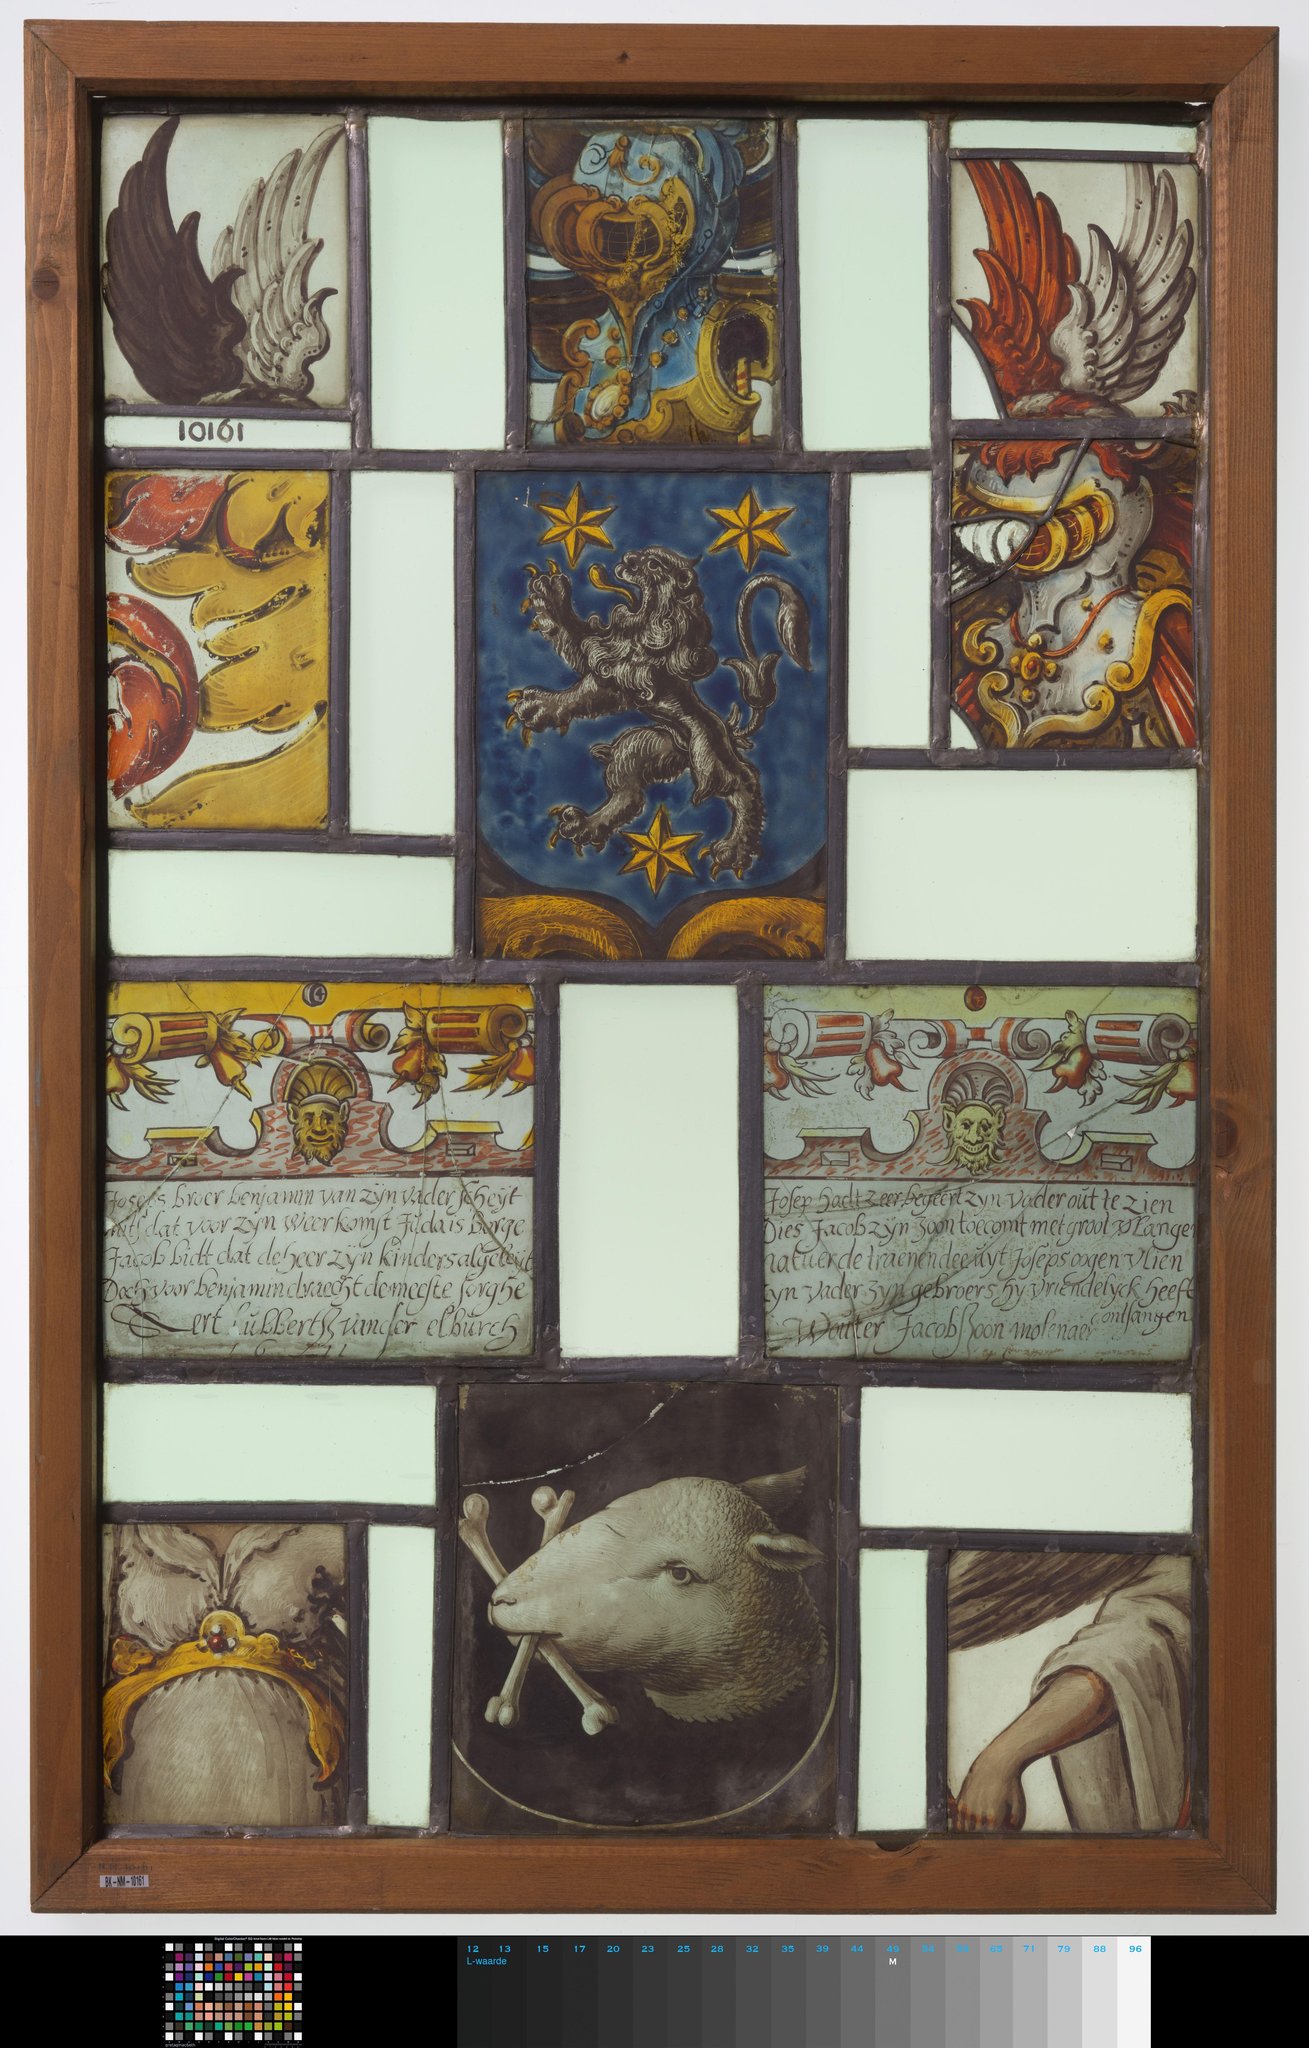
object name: light window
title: Ruit met fragmenten van een wapenschild met helm, klimmende leeuw, lambrequins, cartouches met inscripties en een schild met schapenkop met beenderen in de bek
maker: Anonymous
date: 1600-1699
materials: glass, lead, pigment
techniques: leading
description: Ruit met fragementen van een wapenschild met helm, klimmende leeuw, lambrequins, cartouches met inscripties en een schild met schapenkop met beenderen in de bek. Inscripties betrekking hebbende op Jozef en Benjamin, waaronder "Bert Lubbertz. van der Elburch 1611" en de ontmoeting van Jozef en Jacob, waaronder "Wouter Jacobszoon Molenaar en 16..".